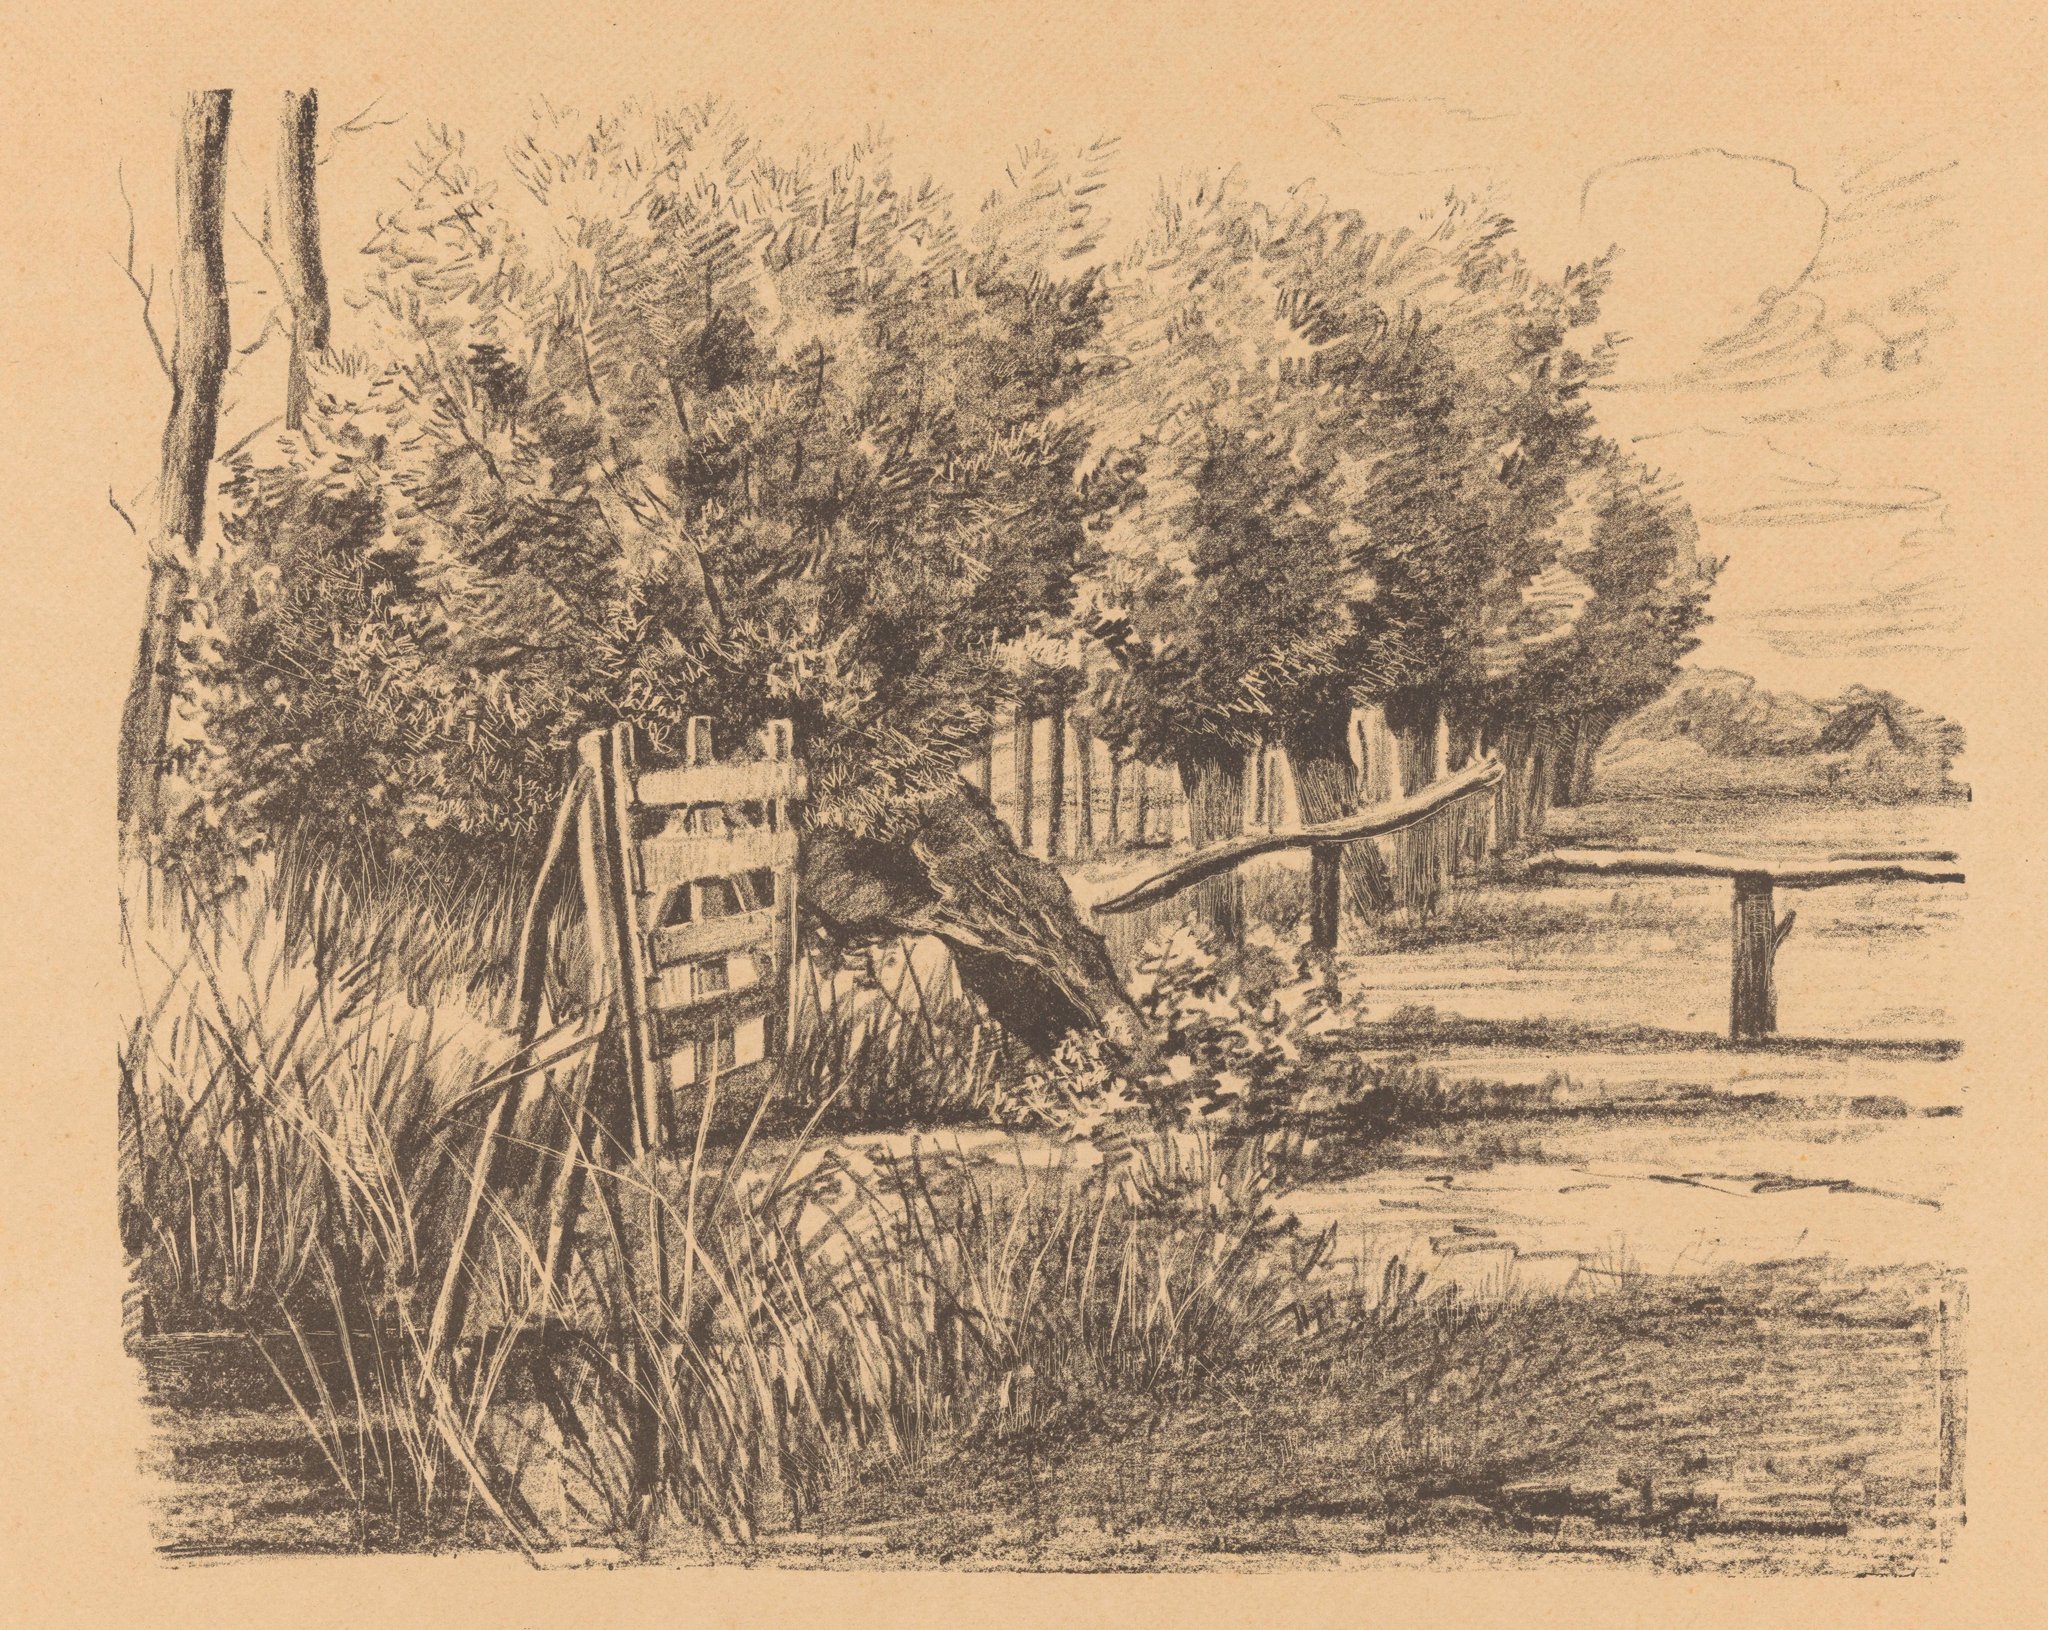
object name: print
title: Wilgen en een hek bij een sloot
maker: gerrit van dokkum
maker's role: painter, print maker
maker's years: 1870-1931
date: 1880-1931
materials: paper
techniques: lithograph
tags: fence, wall, paling, trees: willow, small canal, ditch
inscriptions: collector's mark: Lugt 2760, collector's mark: Lugt 2228